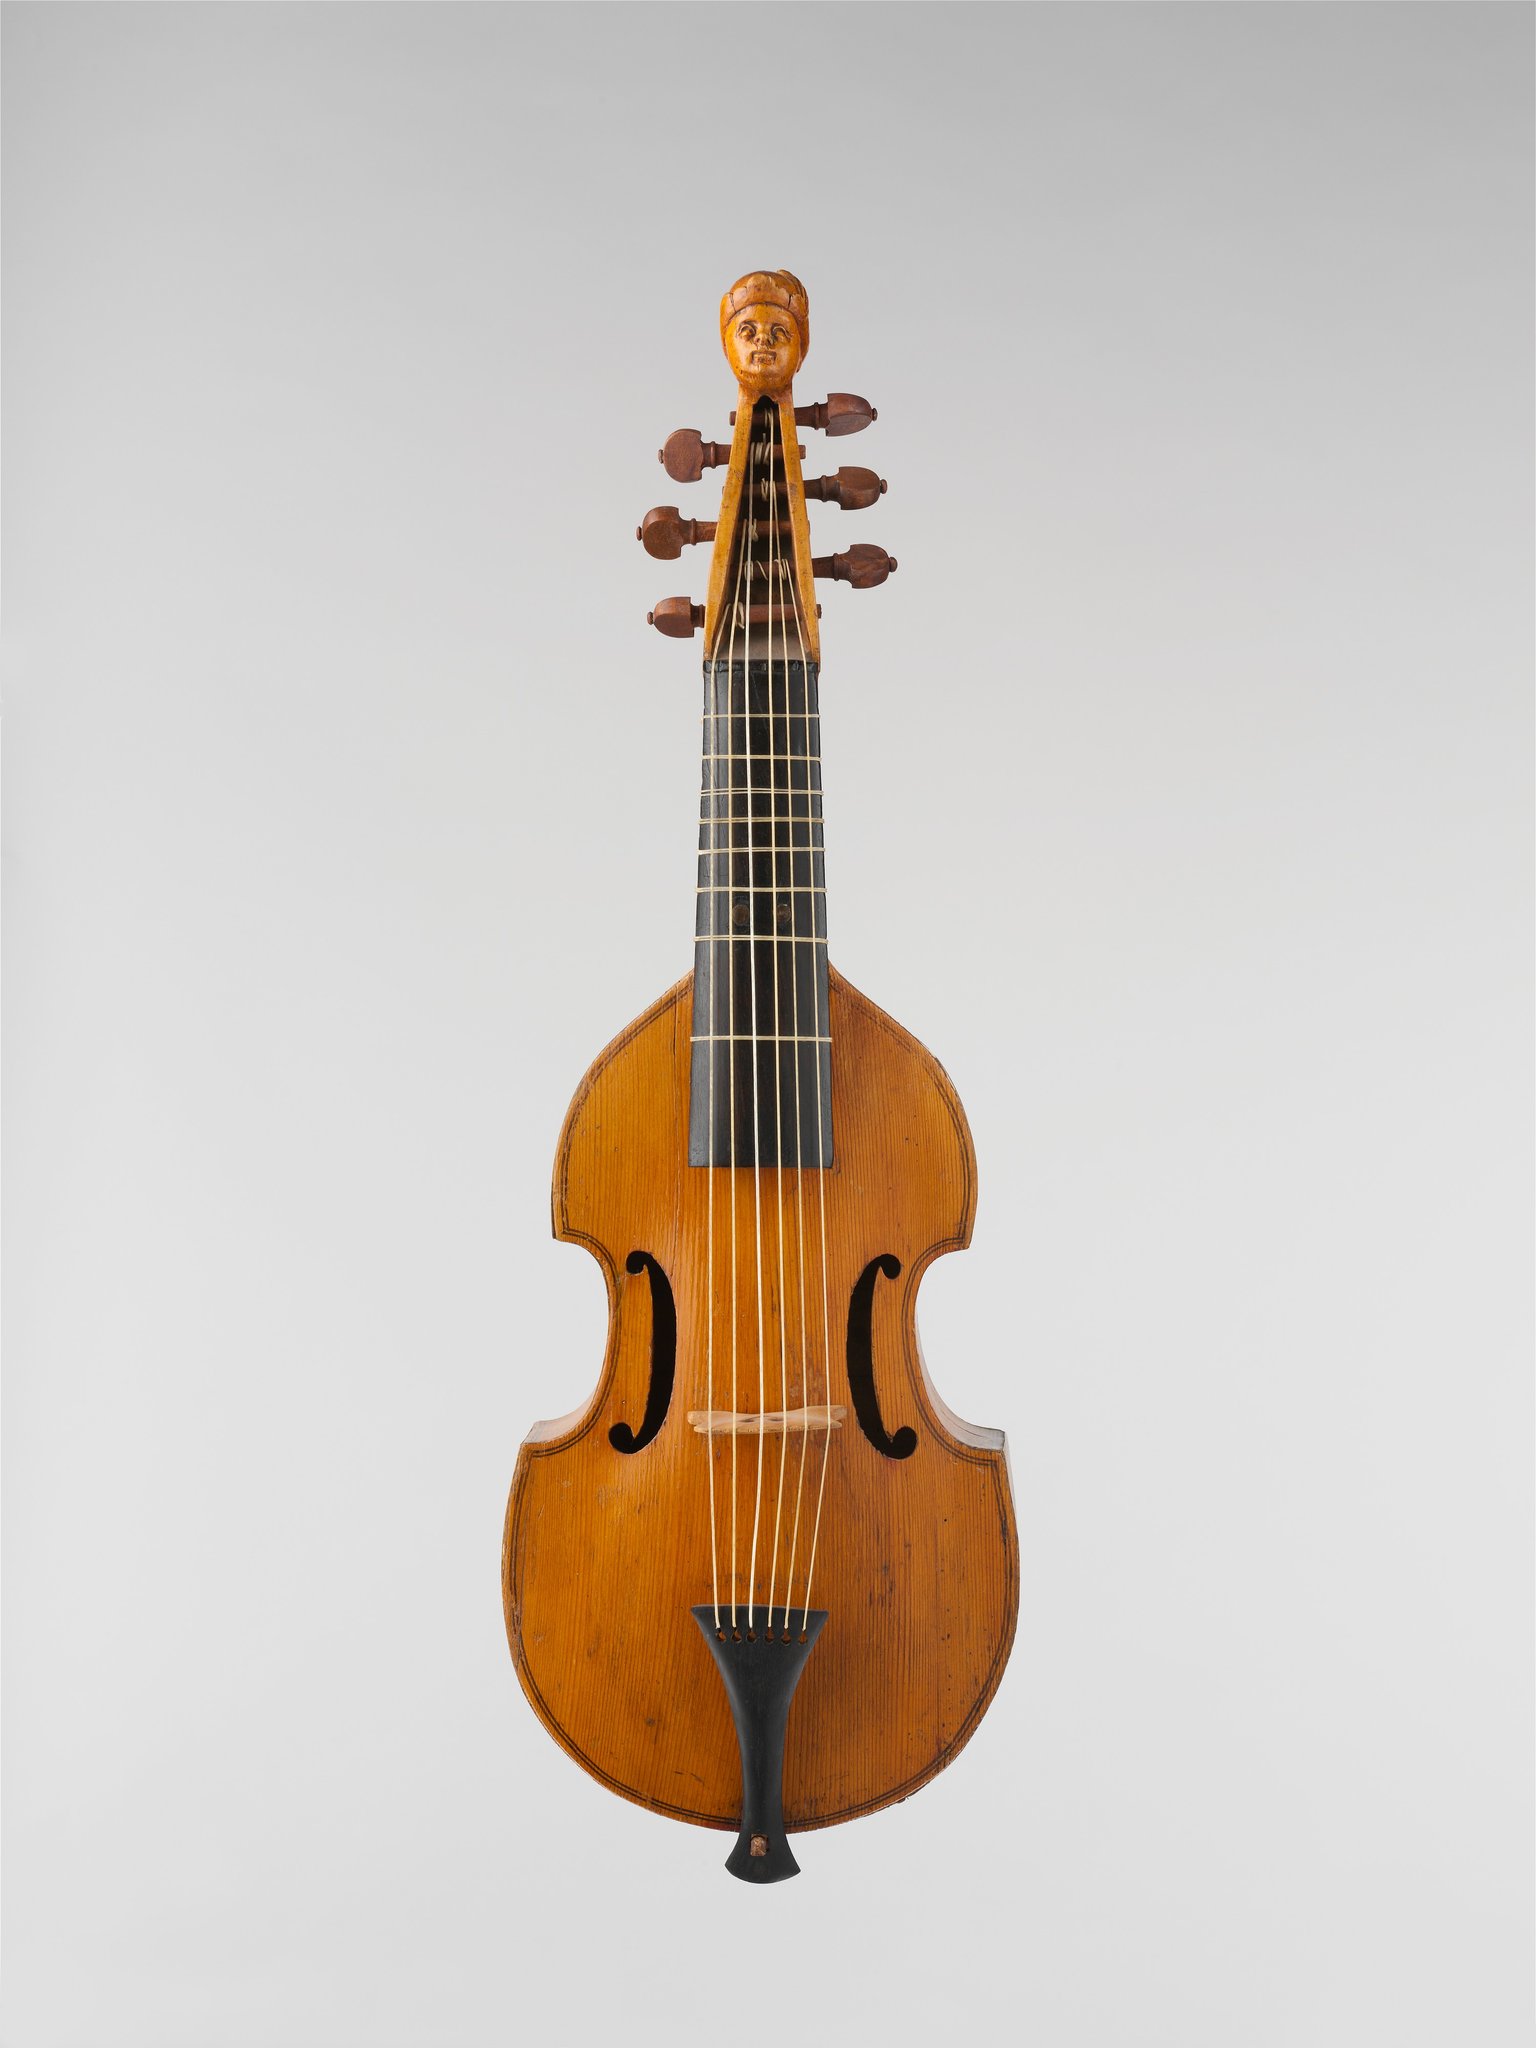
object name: treble viol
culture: french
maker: cabroly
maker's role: maker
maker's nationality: italian, active france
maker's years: 1730-1749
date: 1730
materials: wood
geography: france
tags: heads